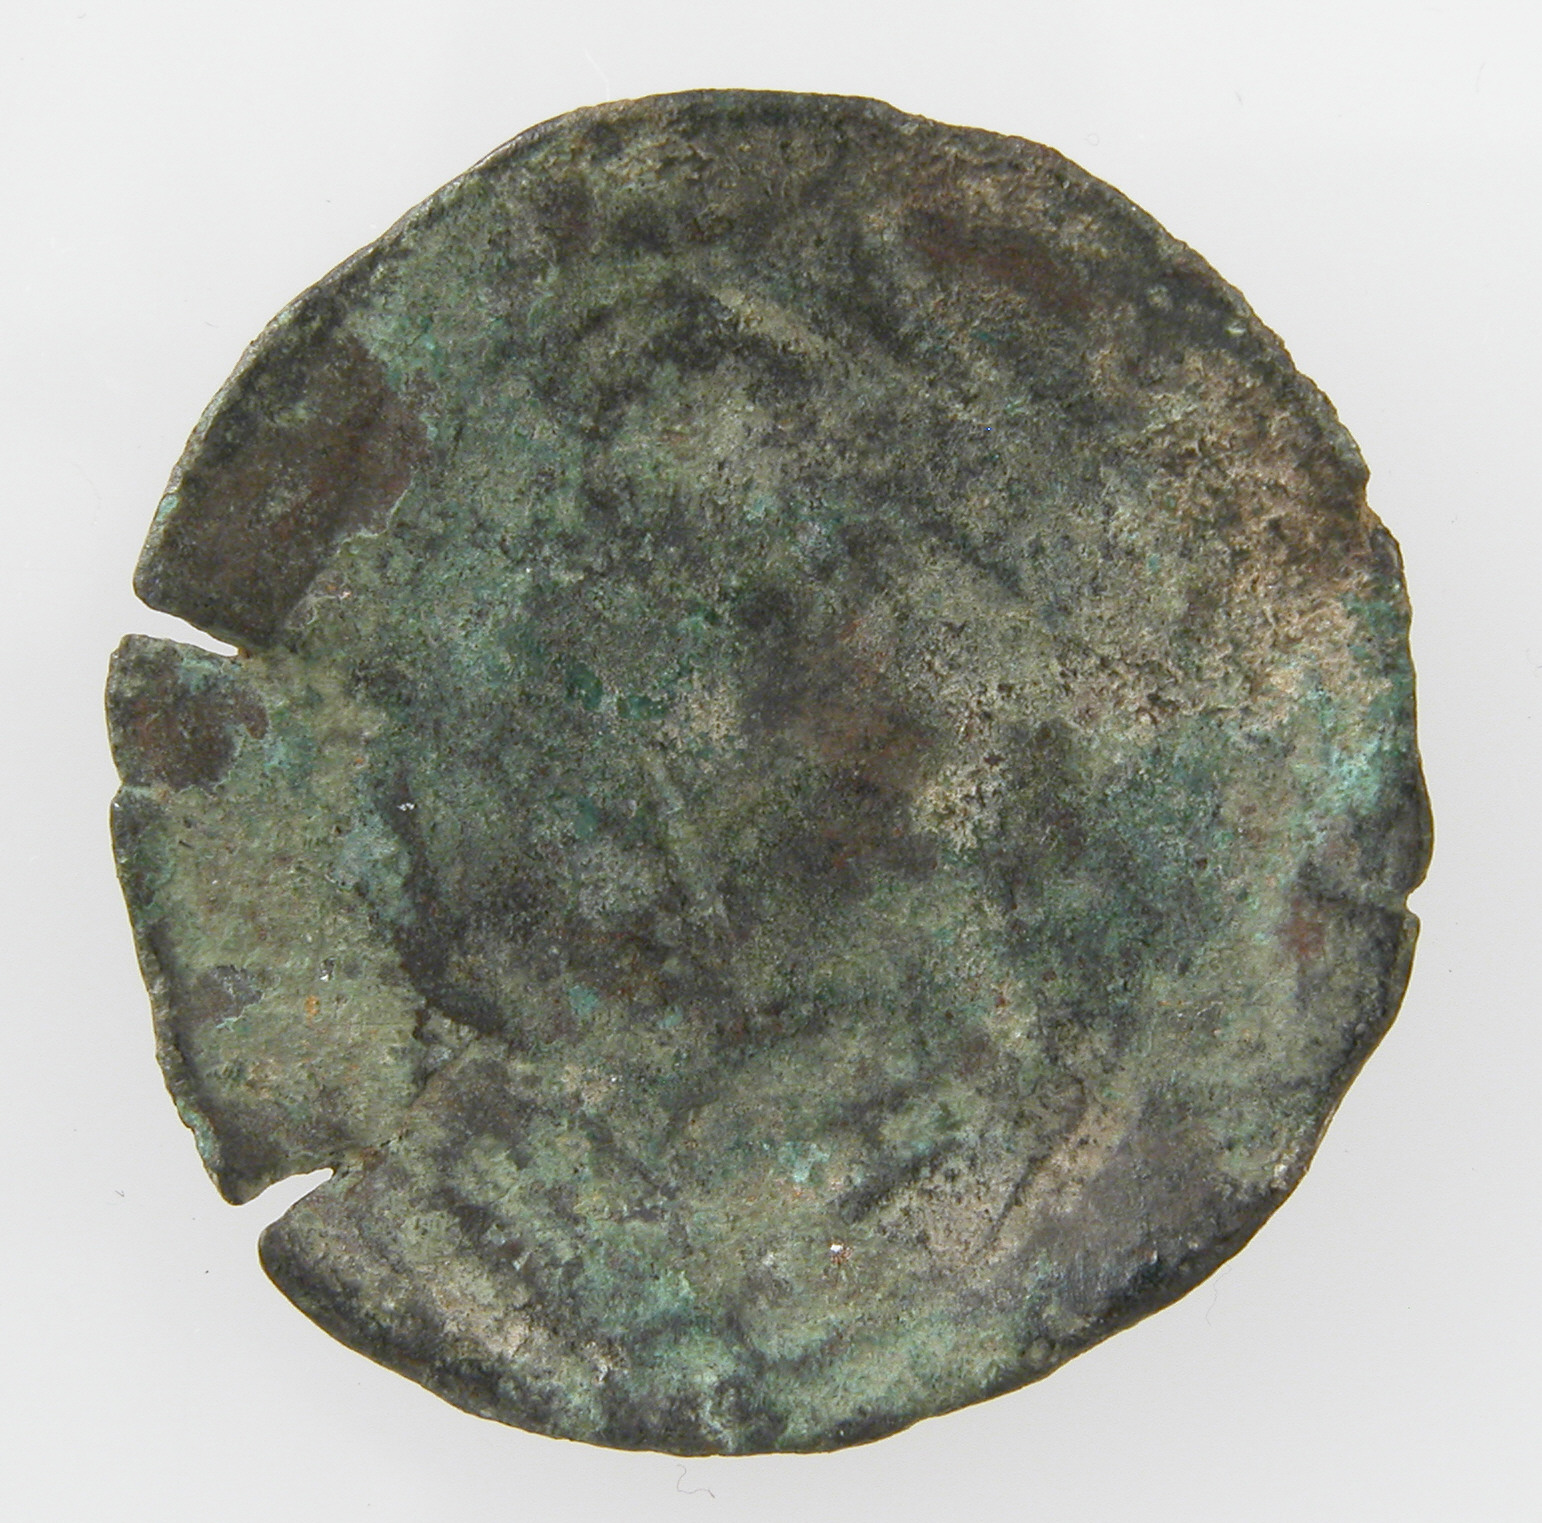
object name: disk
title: Plain Disk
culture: roman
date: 250-500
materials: copper alloy